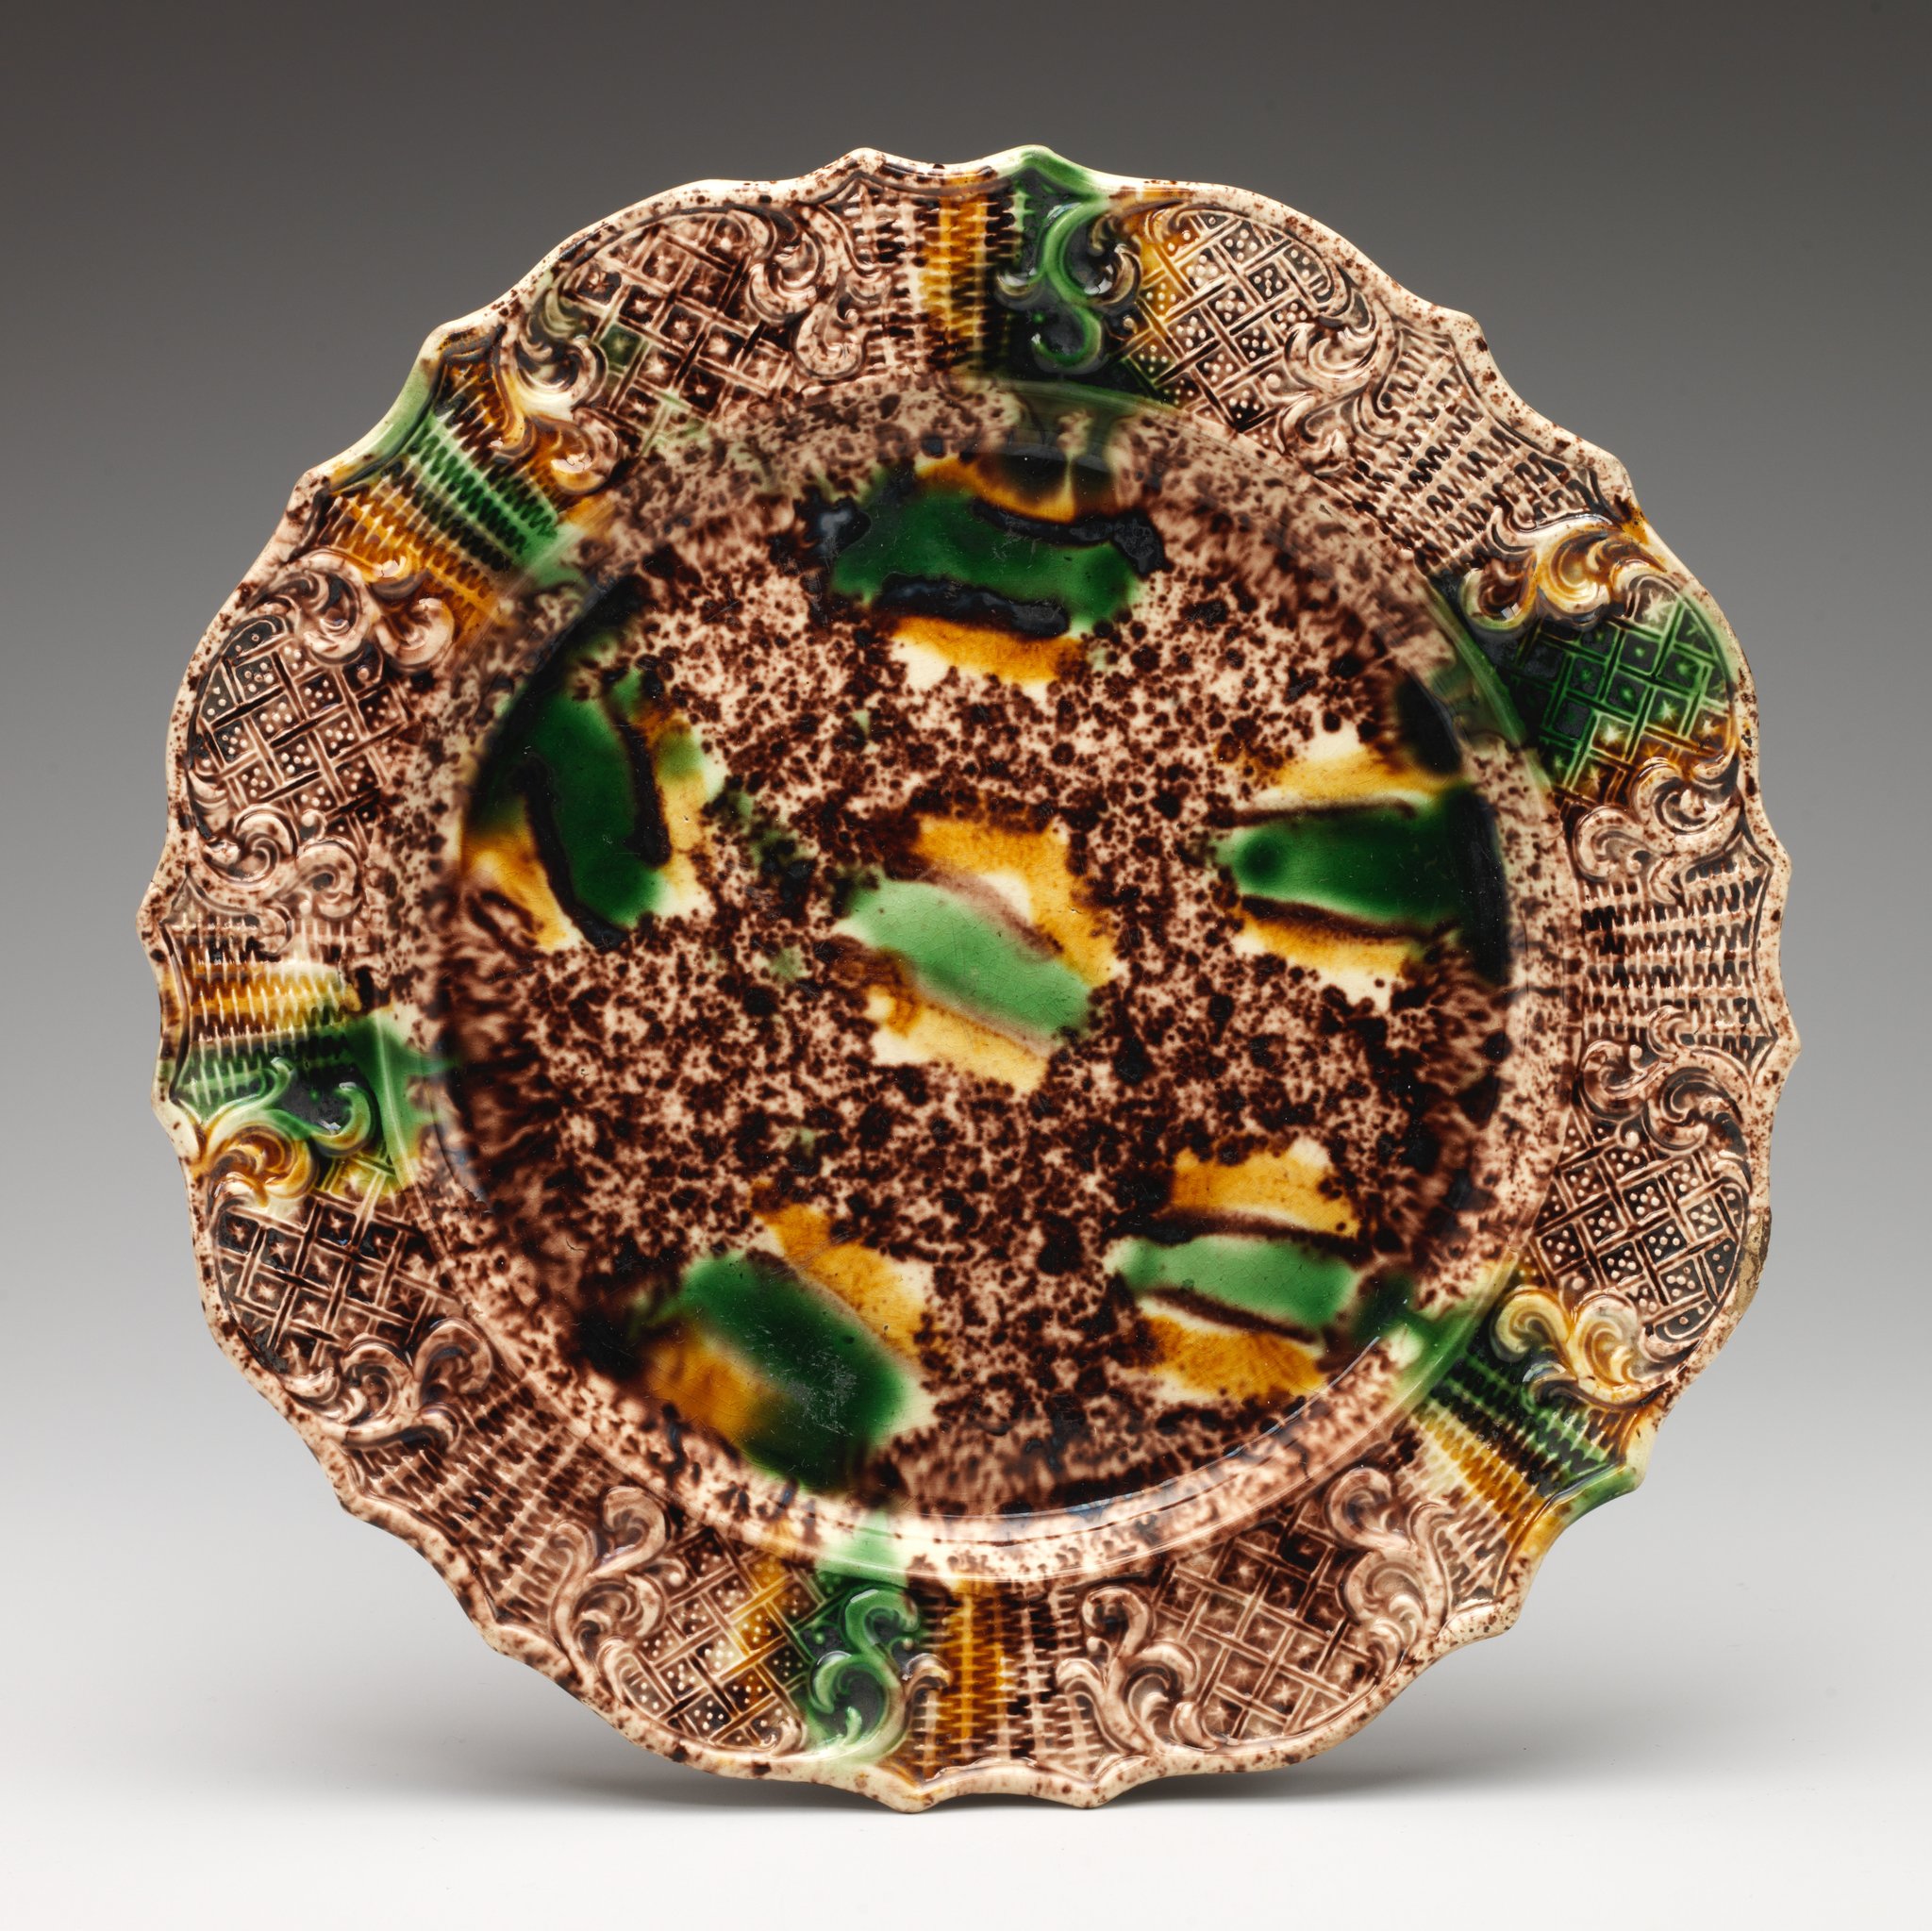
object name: plate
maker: whieldon type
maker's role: maker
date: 1750-1770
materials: shell